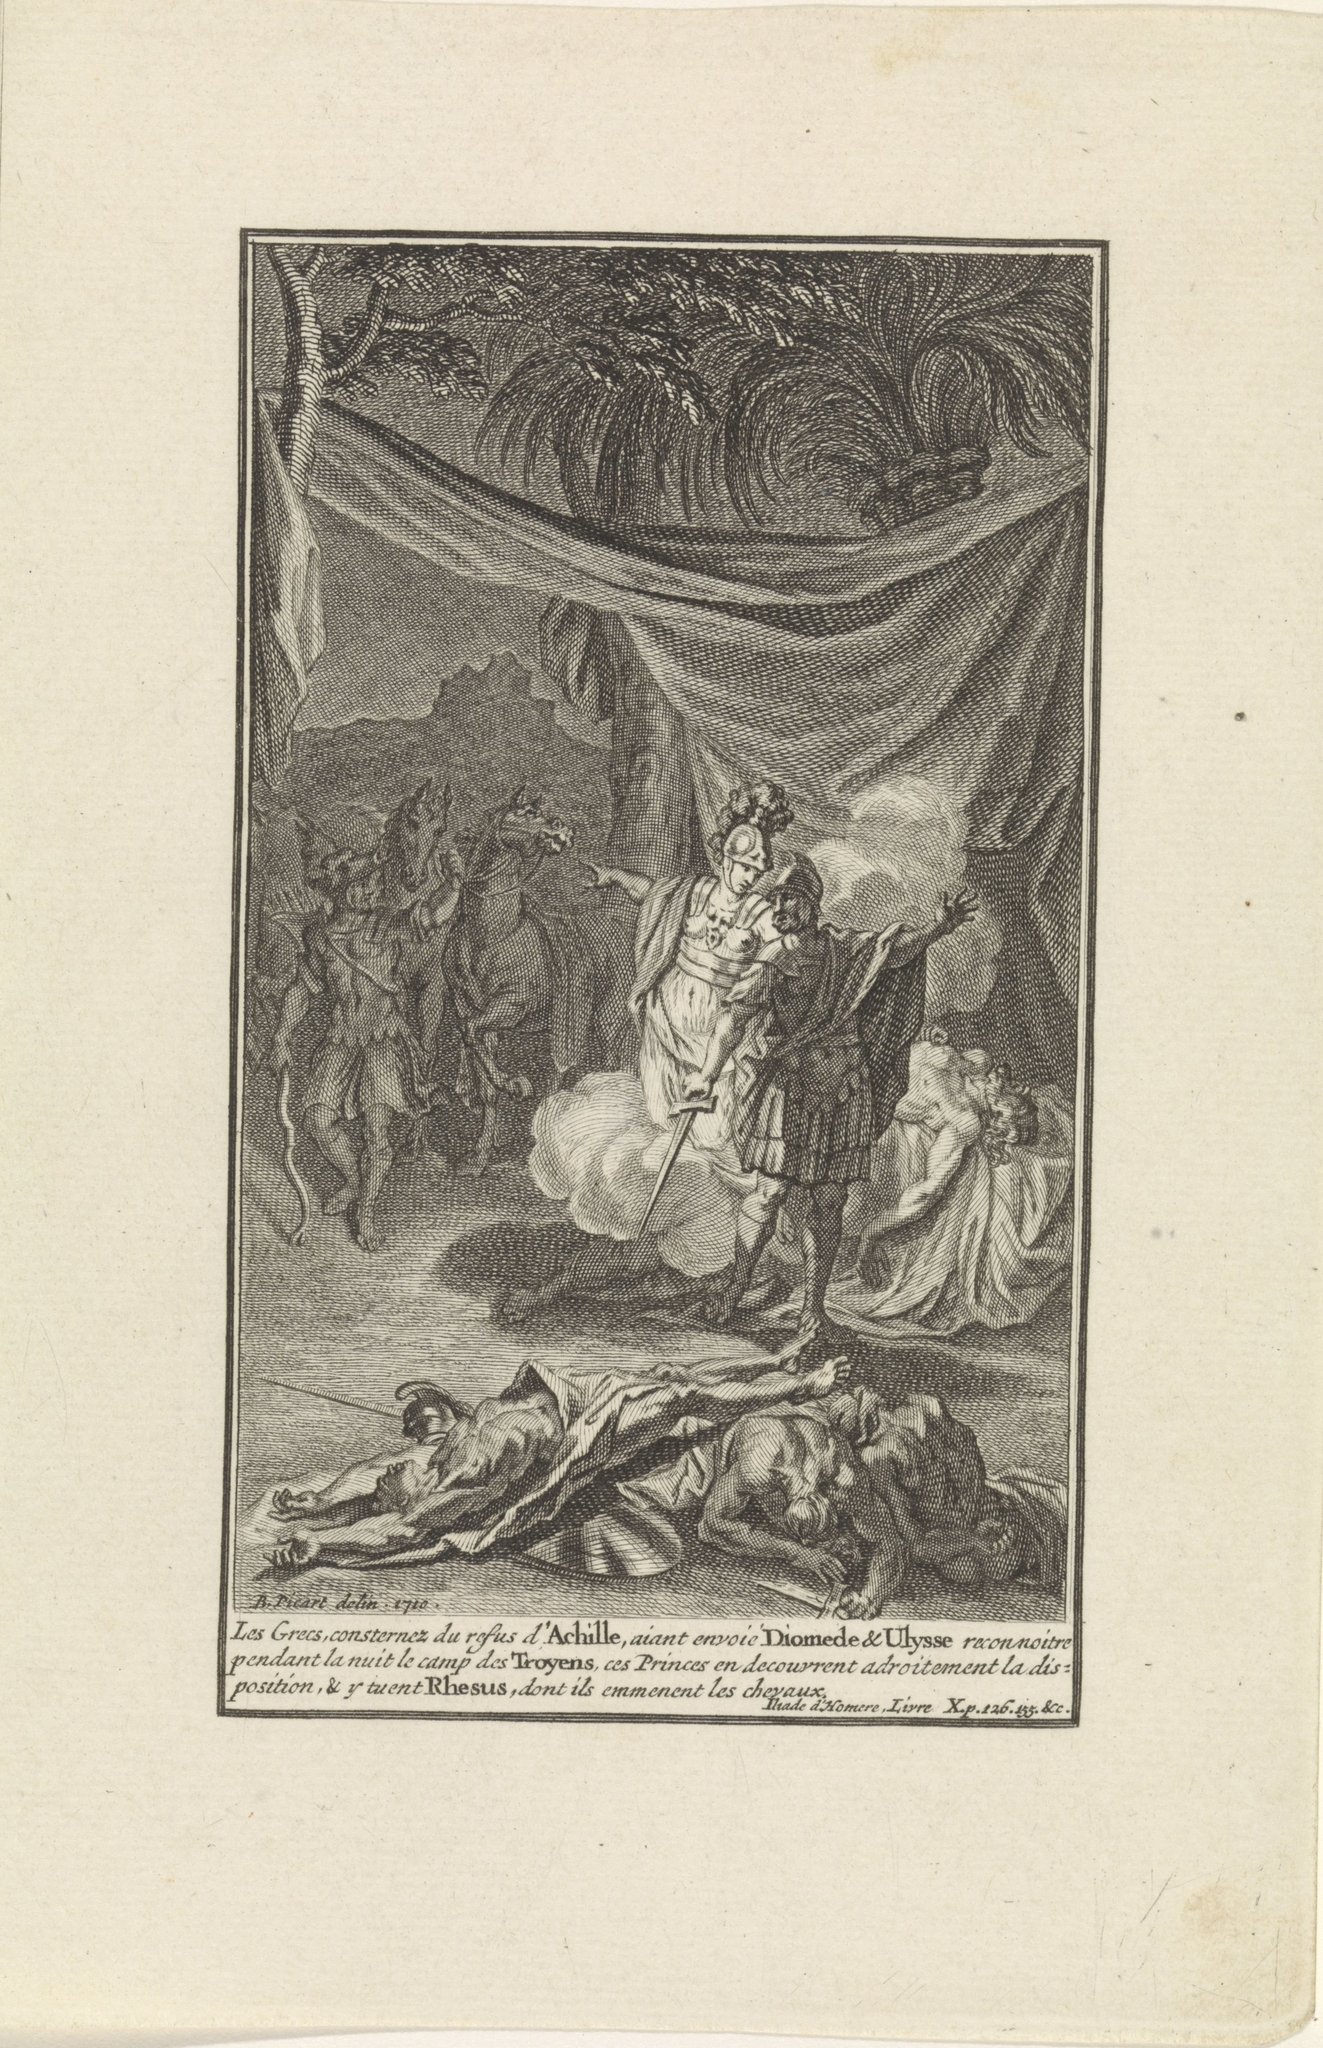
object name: print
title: Diomedes doodt Rhesus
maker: bernard picart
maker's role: draughtsman, print maker, publisher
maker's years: 1673-1733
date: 1710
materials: paper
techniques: engraving, etching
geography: amsterdam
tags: ulysses and diomedes kill rhesus and his companions and take away his horses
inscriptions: collector's mark: Lugt 2228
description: Diomedes doodt Rhesus, koning van Thracië. Odysseus steelt de paarden uit het tentenkamp. In de marge een onderschrift in het Frans.